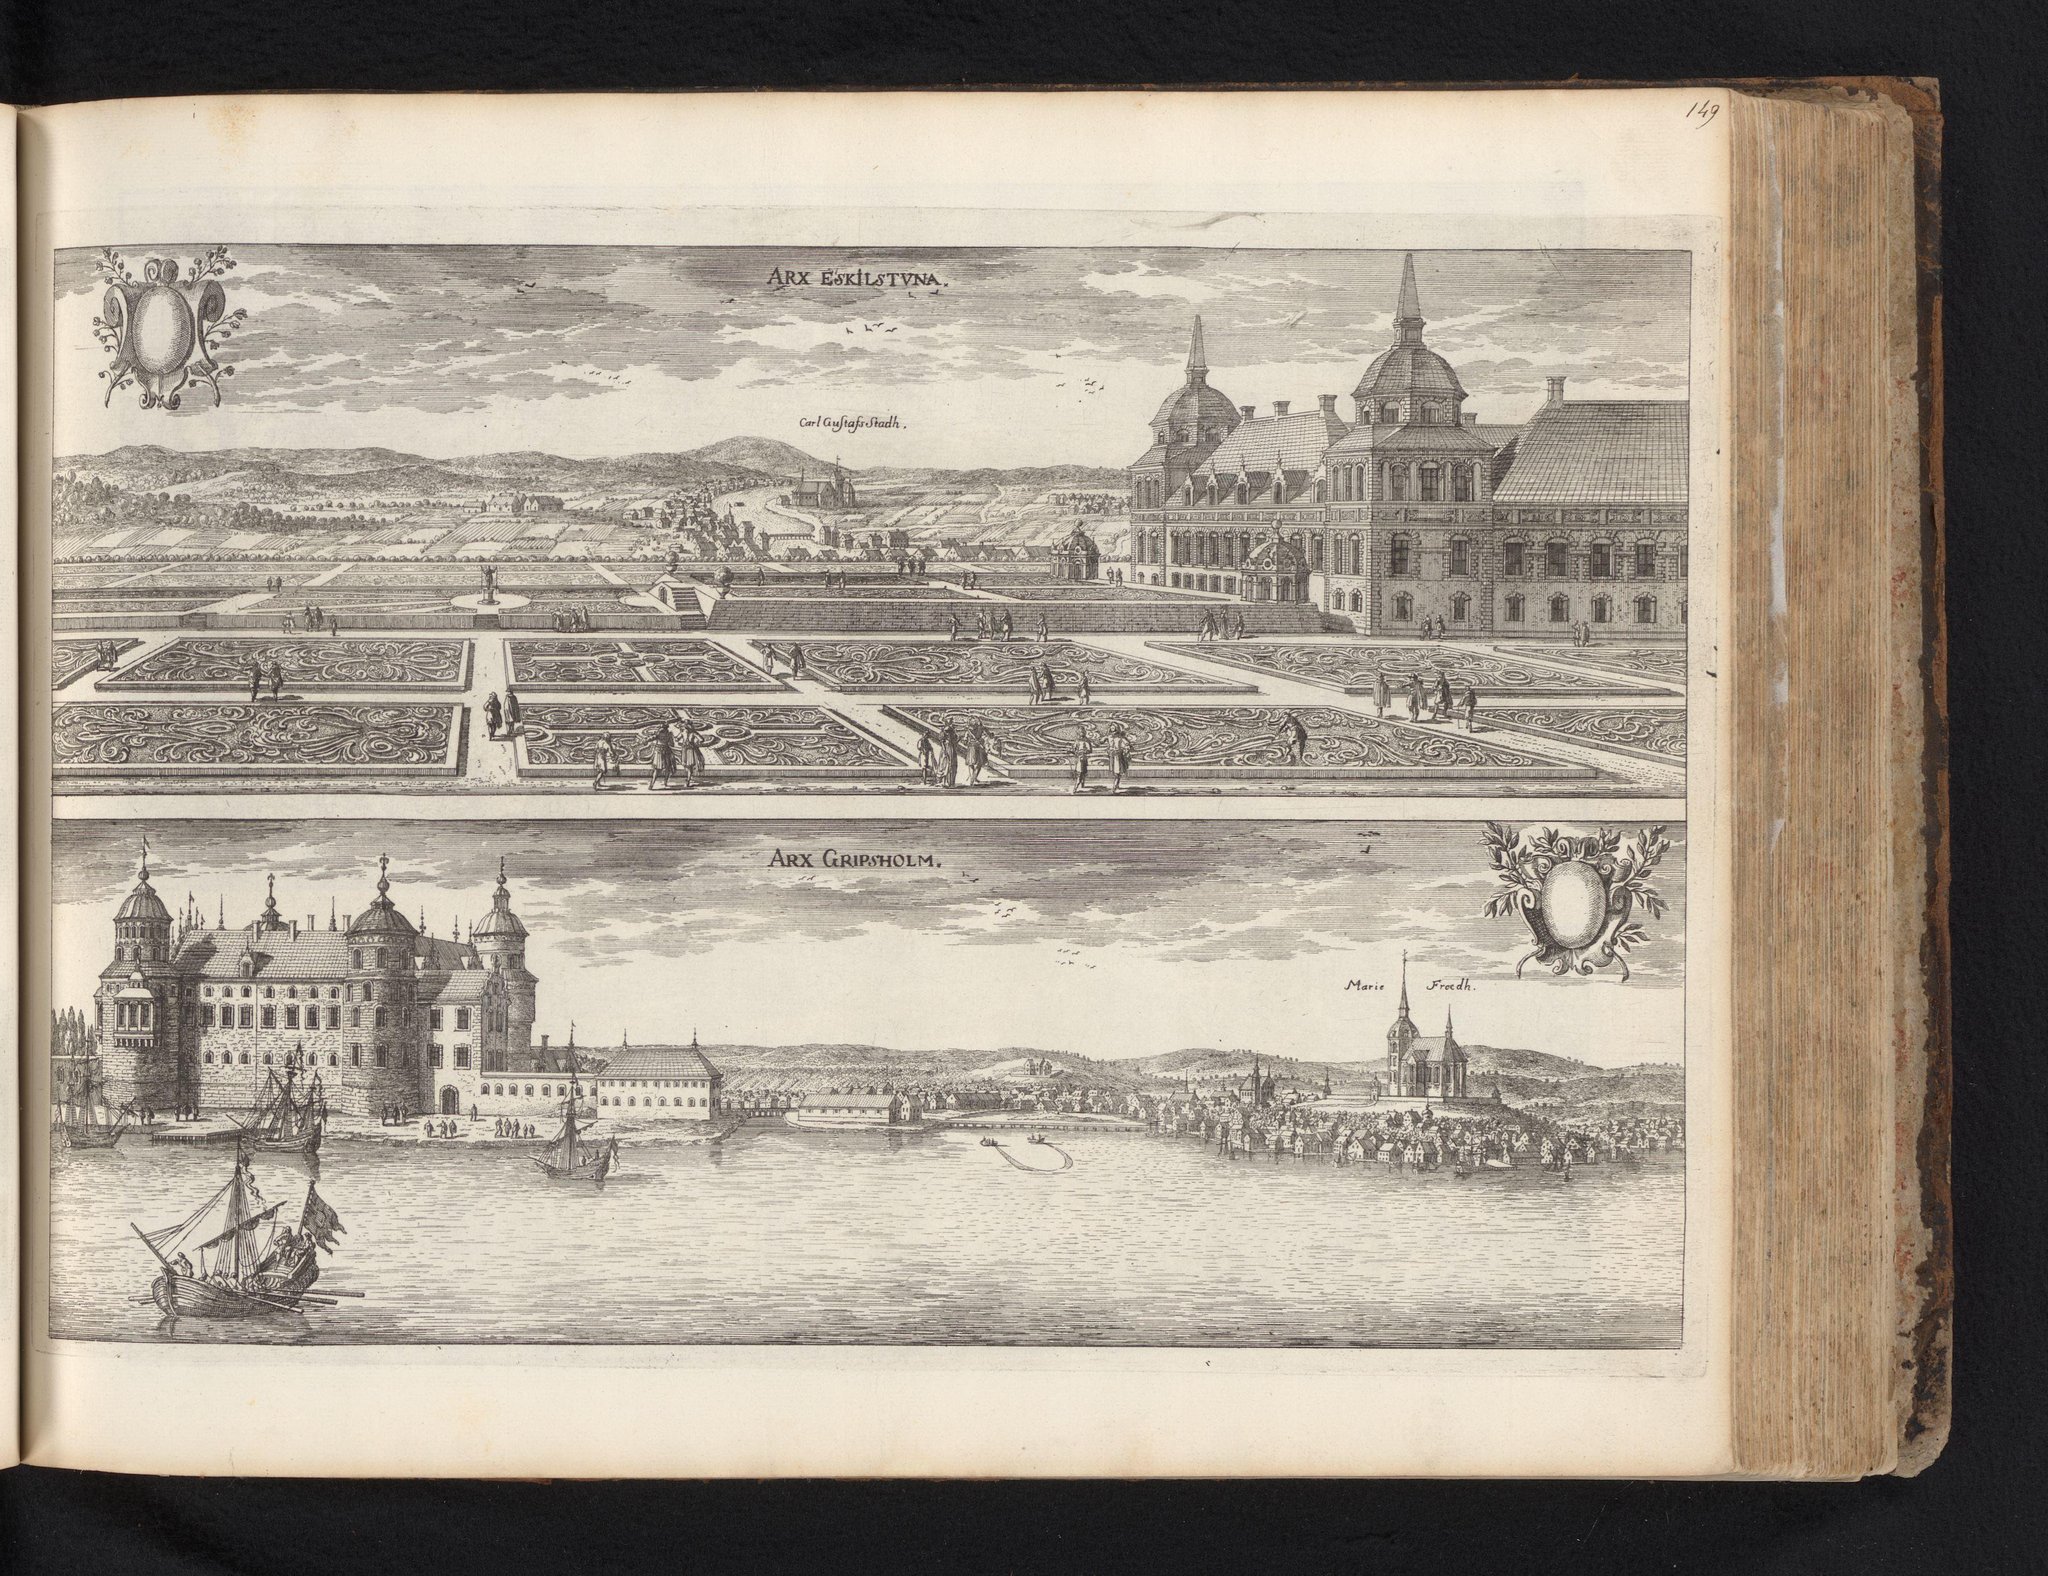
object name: print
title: Suecia Antiqua et Hodierna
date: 1670-1674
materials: paper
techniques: etching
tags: castle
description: Kungliga Biblioteket, 'Suecia': http://www.kb.se/samlingarna/Kartor-bilder/Suecia-antiqua/ (geraadpleegd november 2016).